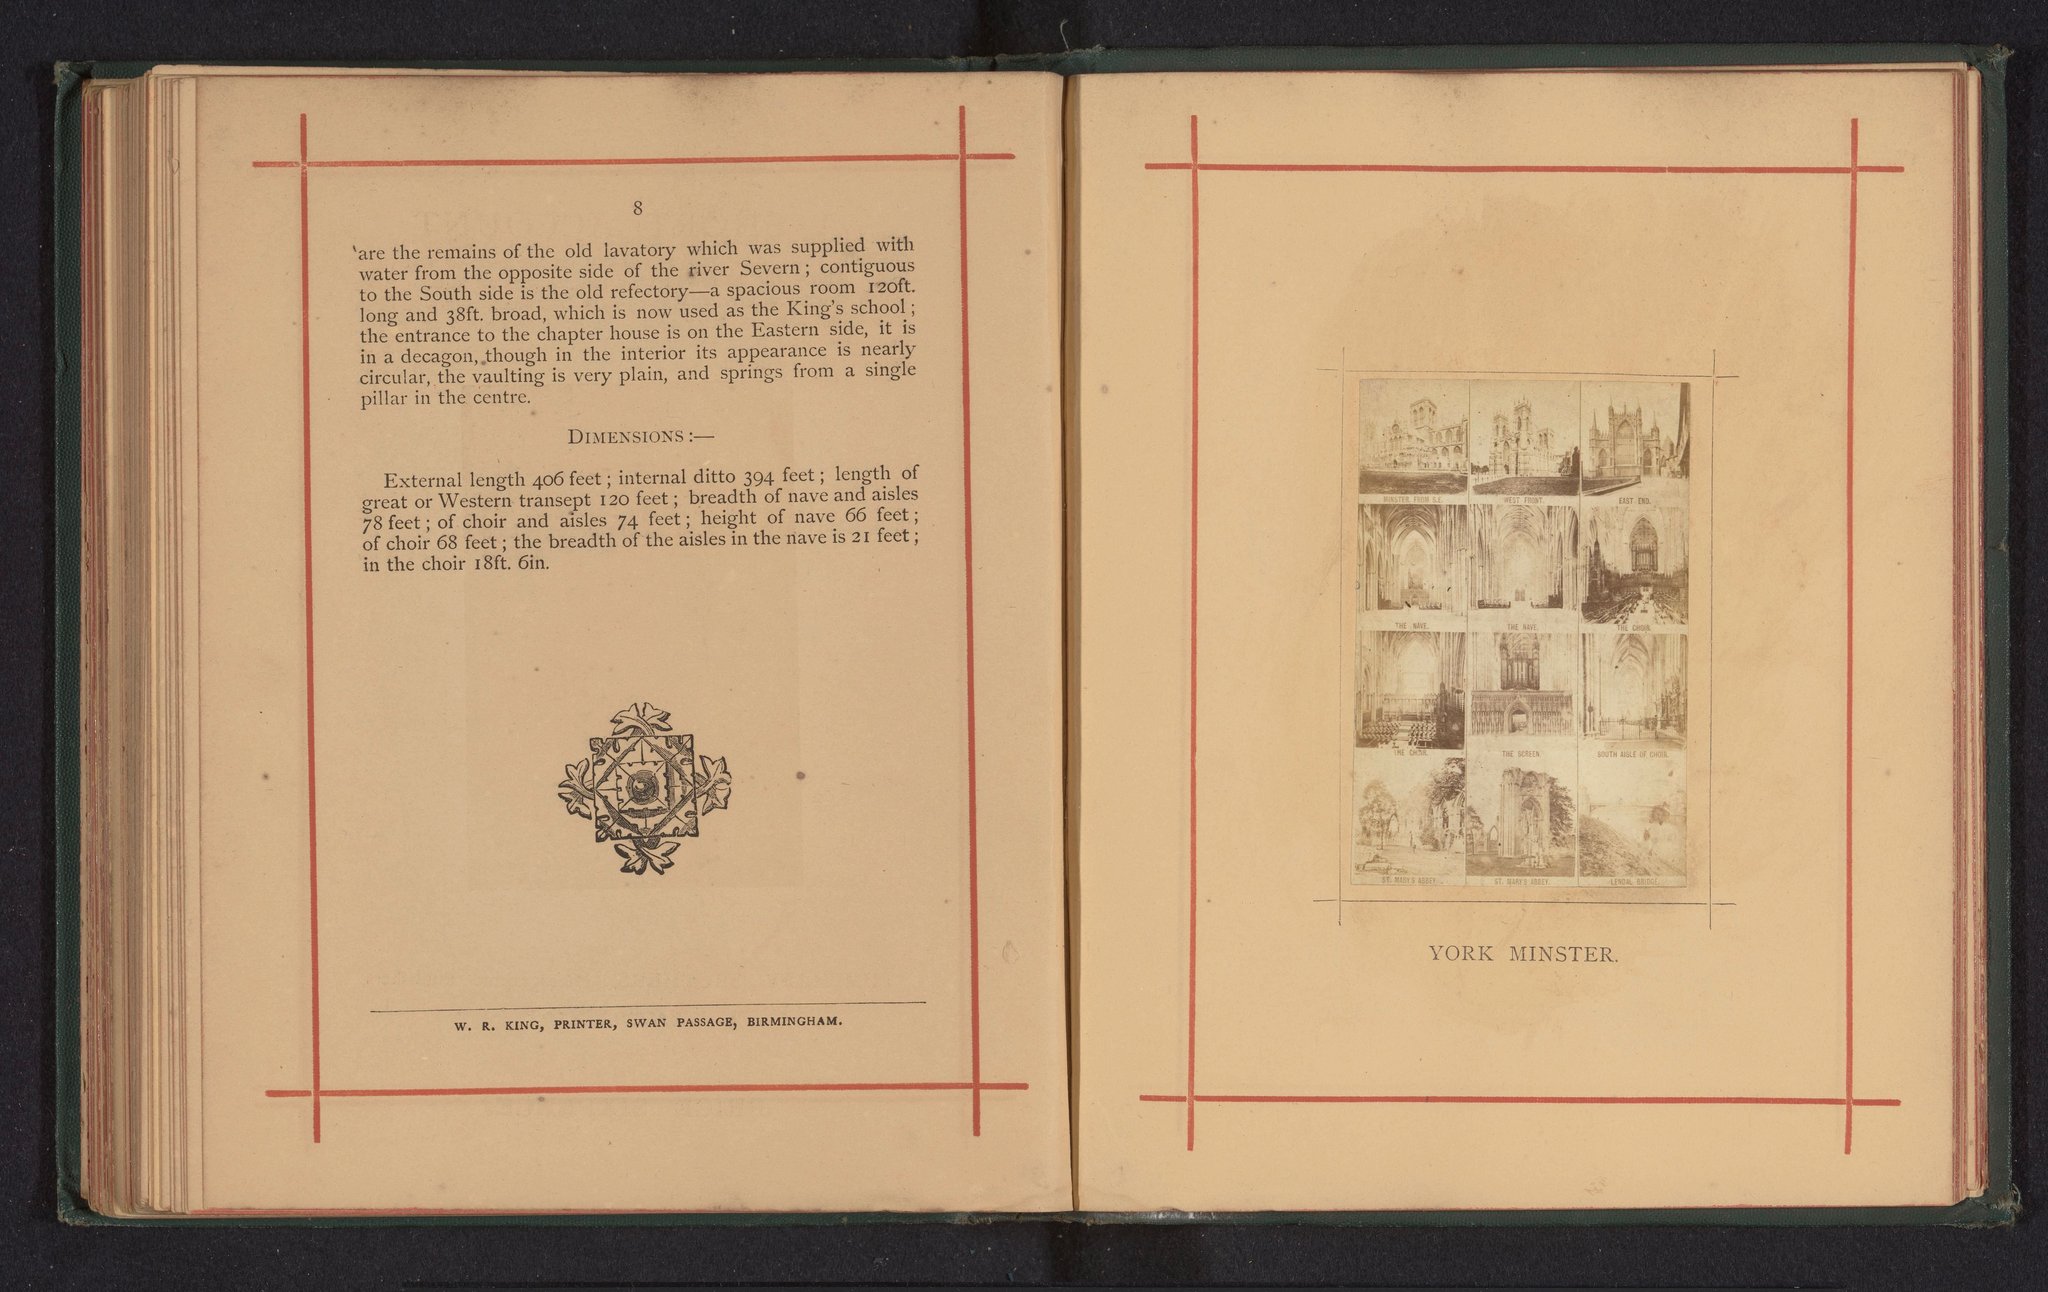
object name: page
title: York Minster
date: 1870-1880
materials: photographic support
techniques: albumen print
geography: york cathedral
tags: church (exterior), ruin of church, monastery, etc., parts of church interior: nave, parts of church interior: choir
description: Van boven naar beneden en van links naar rechts: driemaal gezicht op de kathedraal, tweemala het schip, tweemaal het koor, het koorhek, zijbeuk van het koor, tweemaal gezicht op Saint Mary's Abbey en een brug.